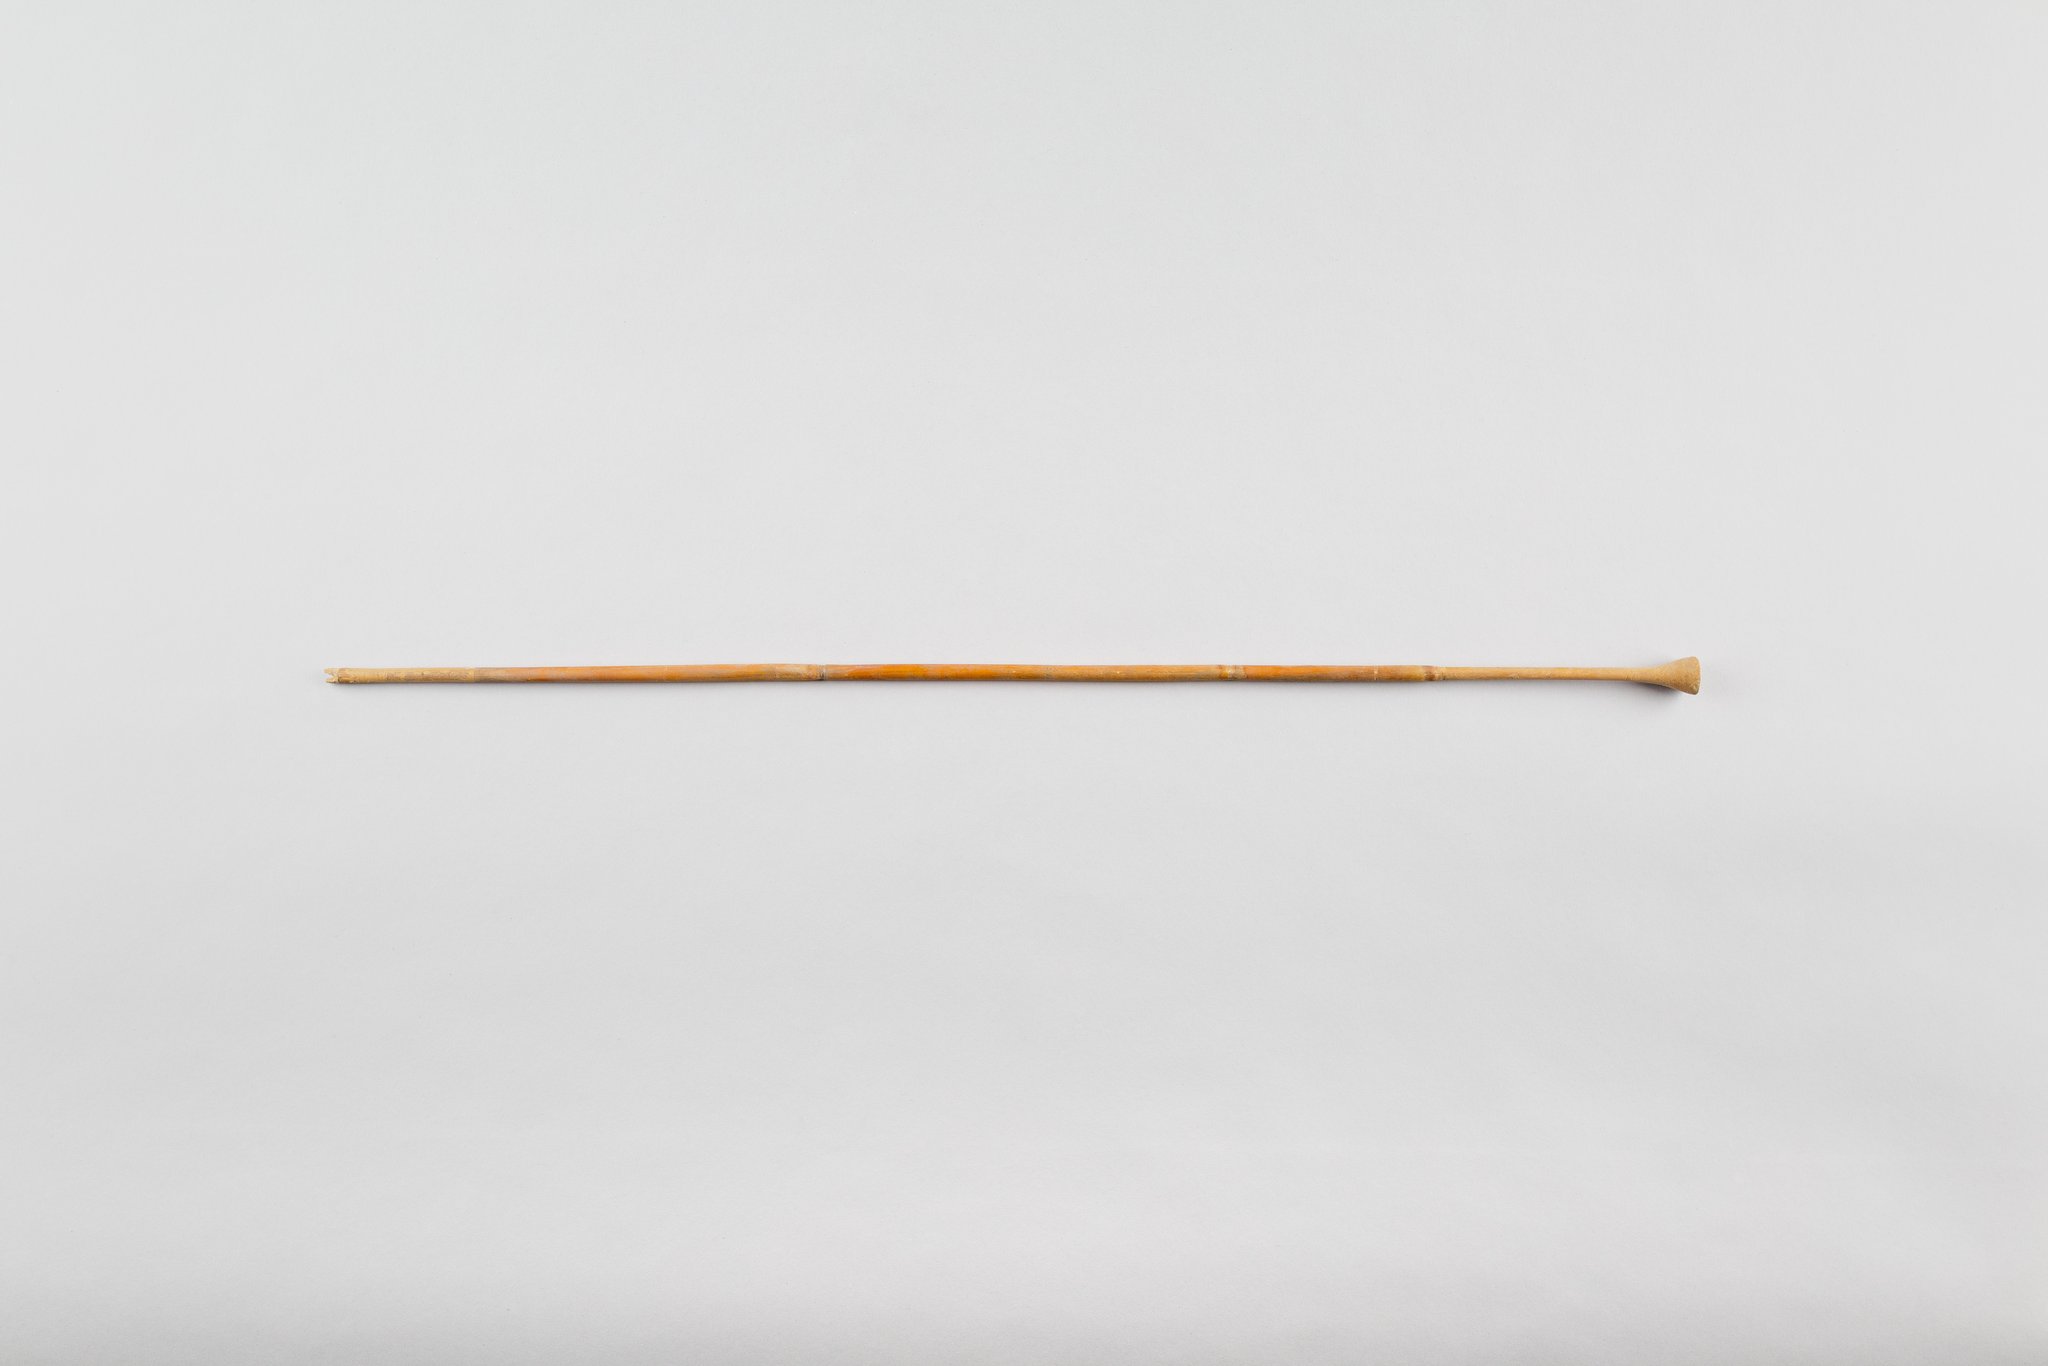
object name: arrow, blunt pile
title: Blunt Tipped Arrow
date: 1479-1458 BCE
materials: wood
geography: egypt